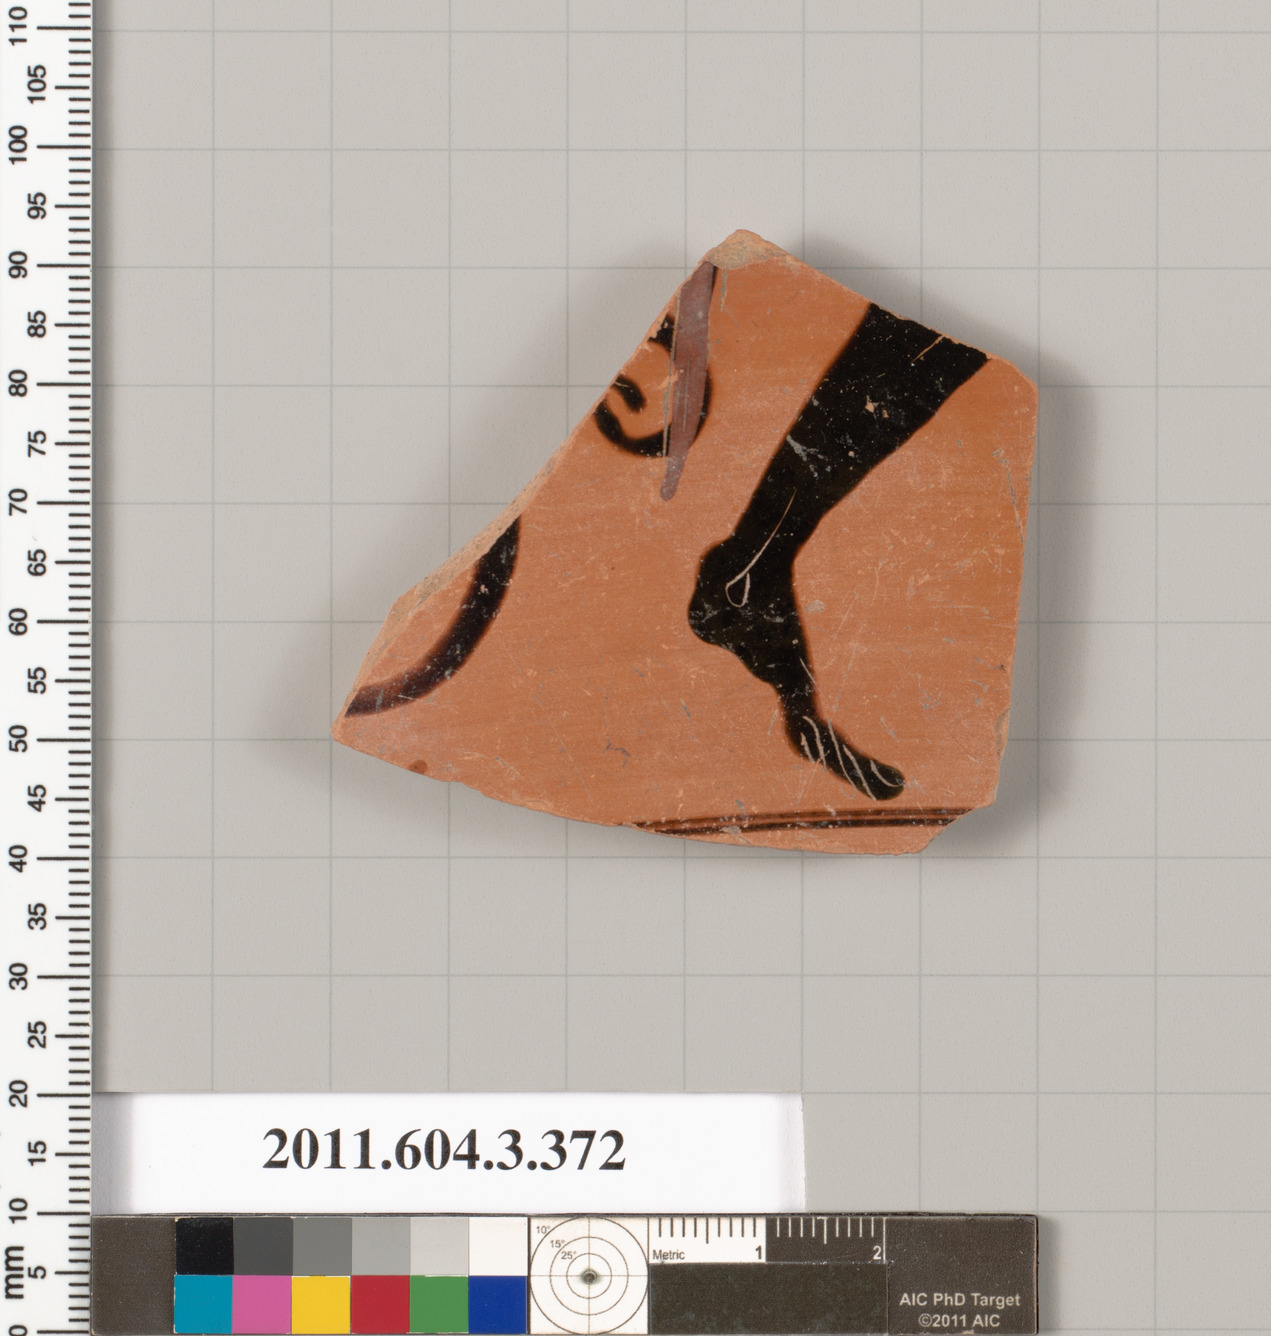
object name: neck amphora fragment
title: Terracotta fragment of a neck-amphora (jar)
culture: greek, attic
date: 534-468 BCE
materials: terracotta